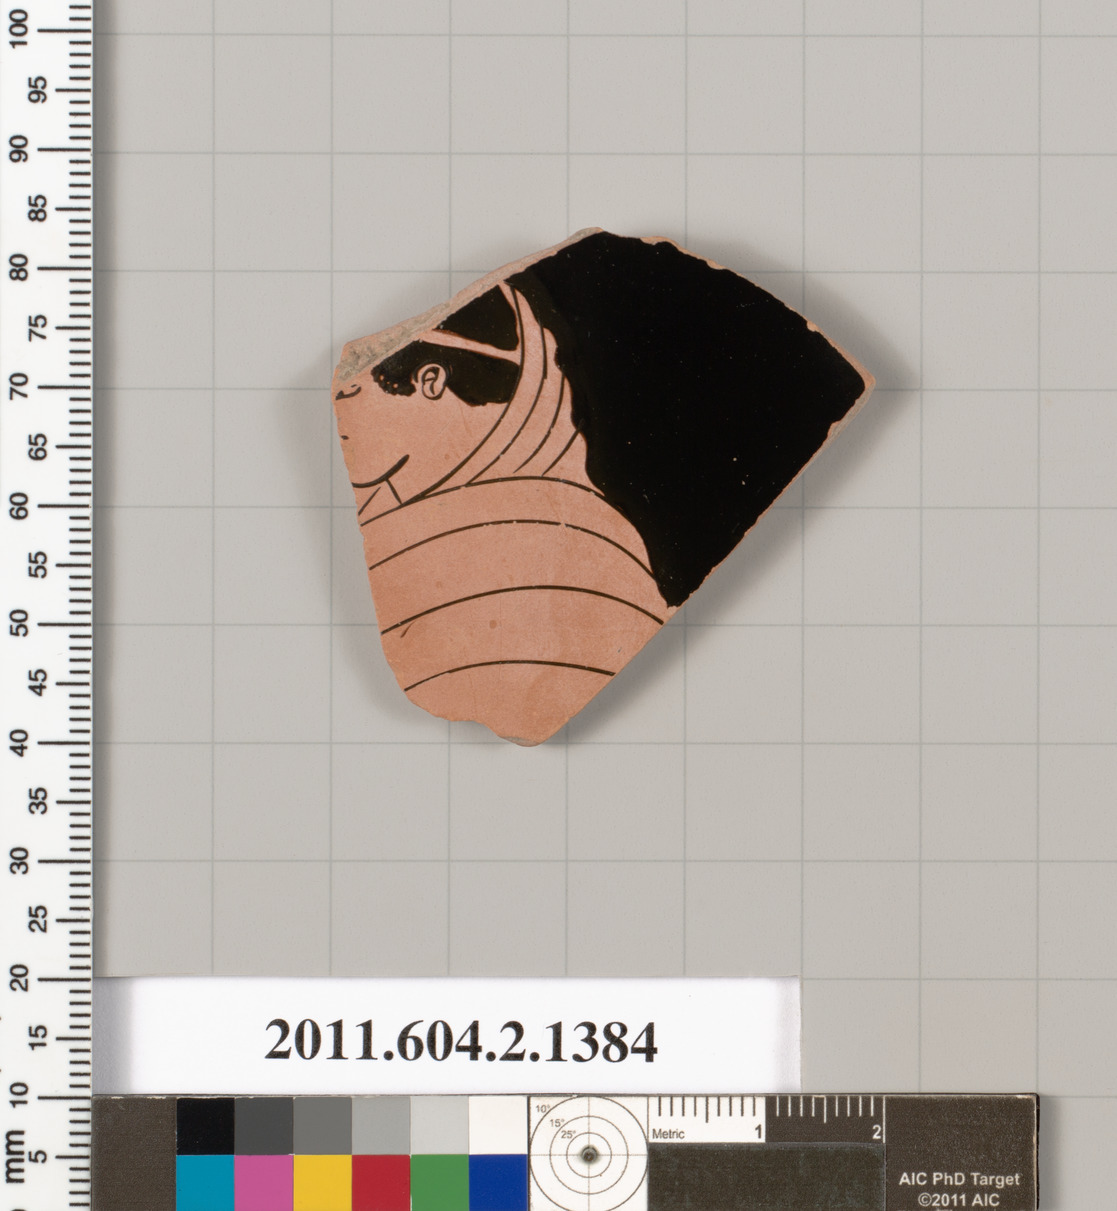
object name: skyphos fragment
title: Terracotta fragment of a skyphos (deep drinking cup)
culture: greek, attic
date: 490-480 BCE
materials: terracotta